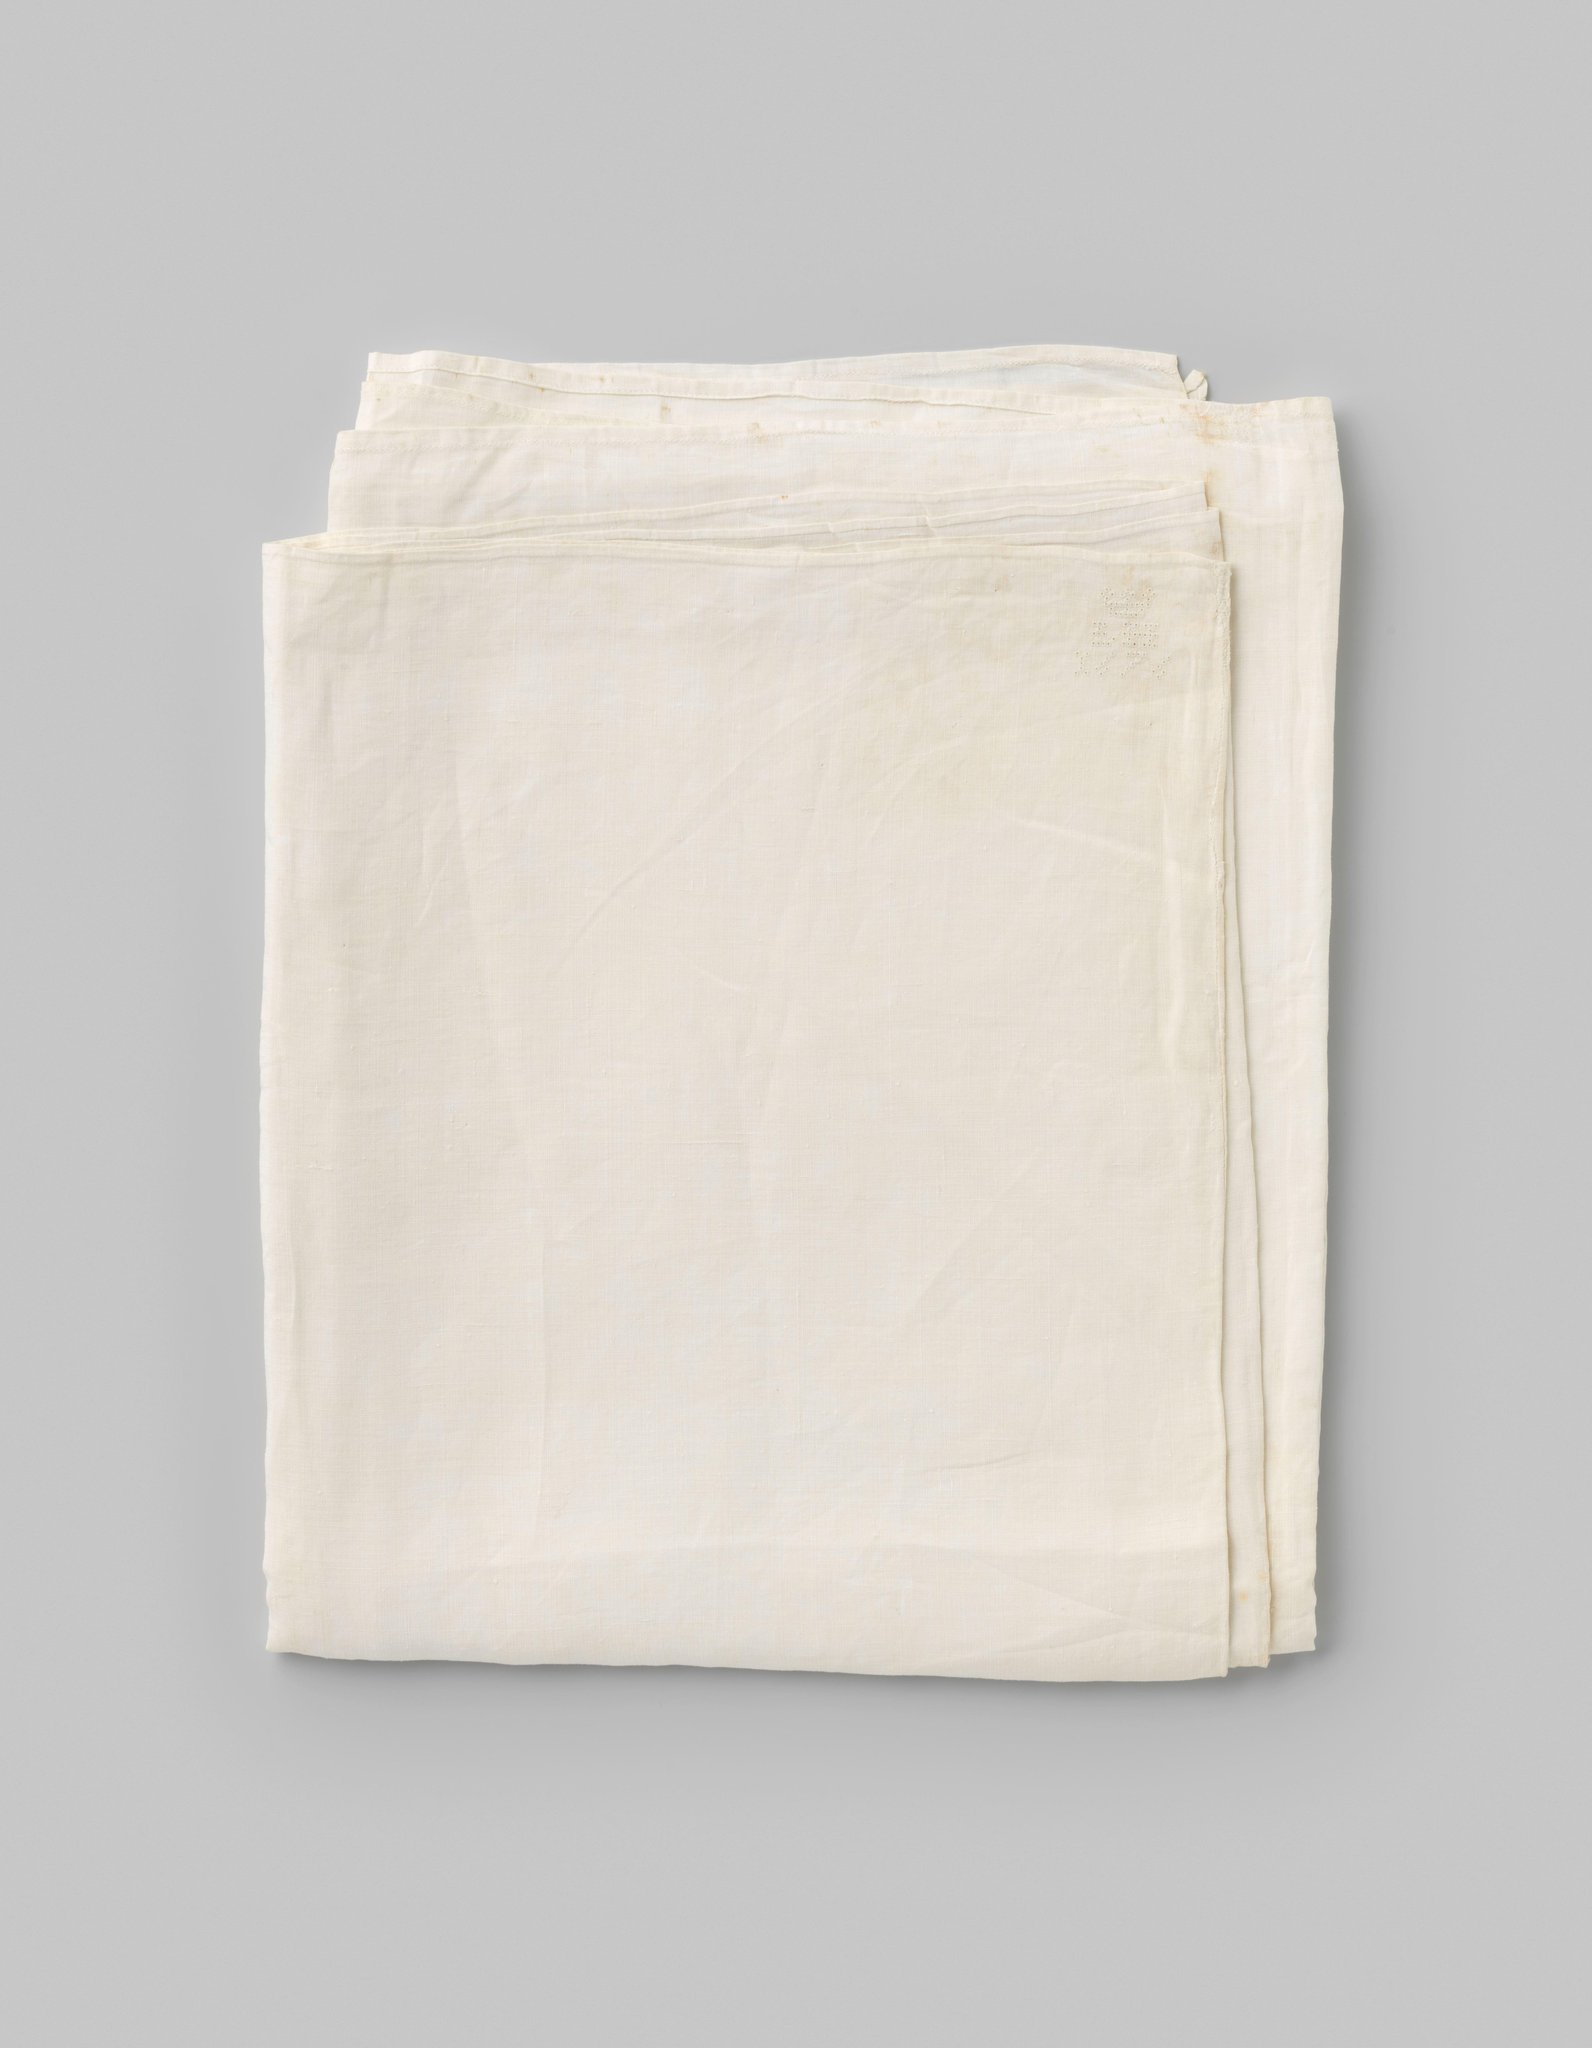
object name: beddenlaken, laken object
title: Laken. Merk: gekroonde letters LH en jaartal 1676.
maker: Anonymous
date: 1676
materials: linen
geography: netherlands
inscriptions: mark: ‘kroon LH 1676’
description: Beddenlaken van linnen, gemerkt in bindgat: gekroonde LH en 1676.